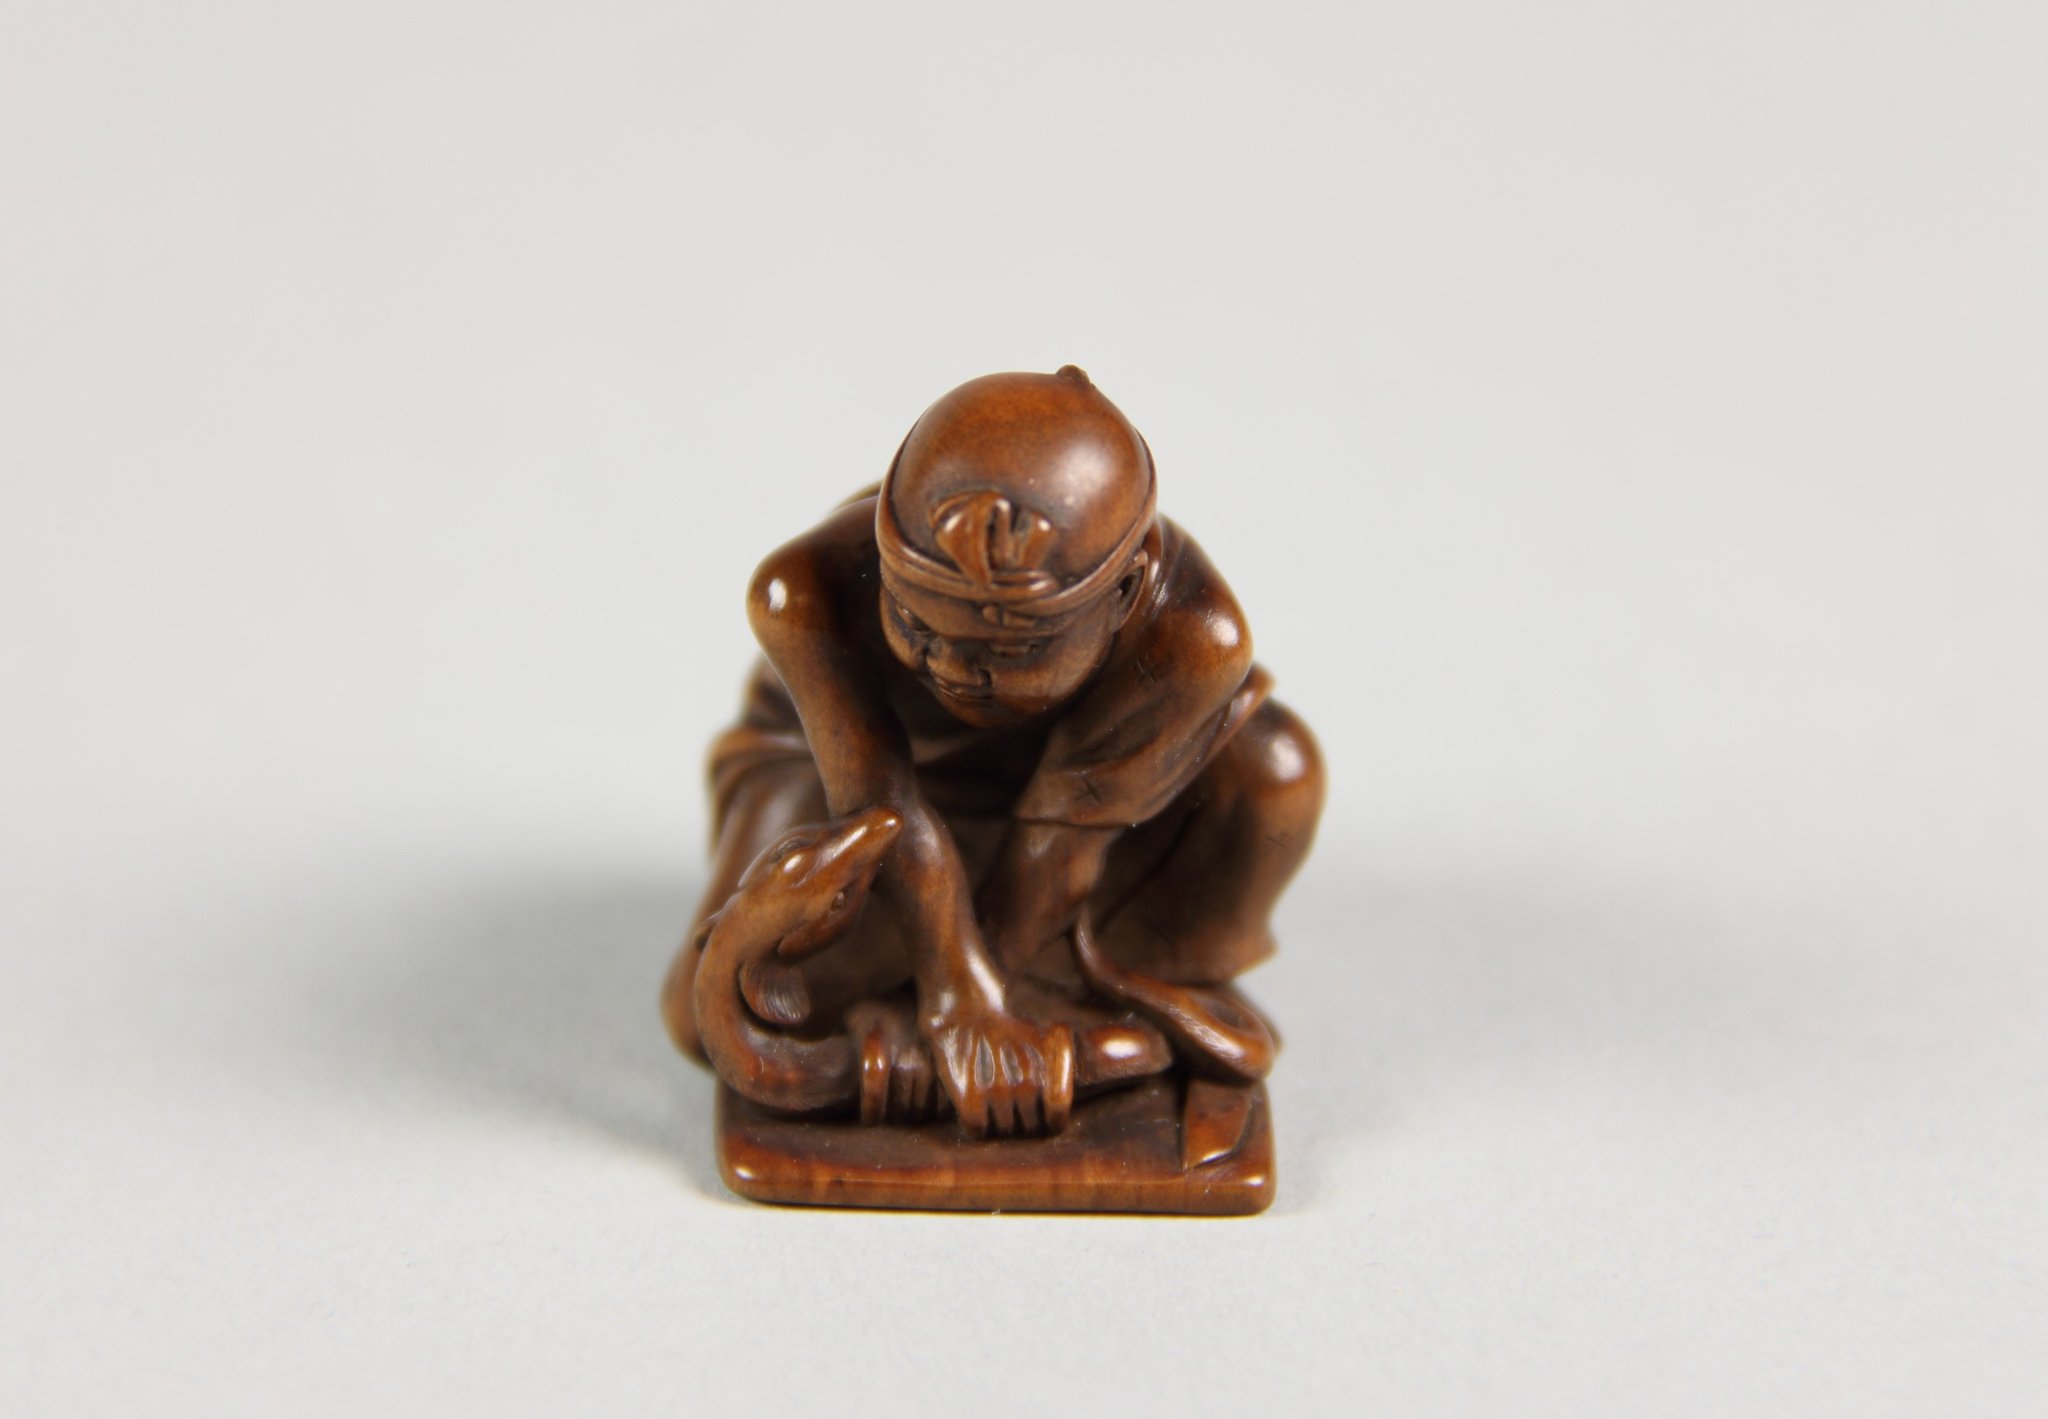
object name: netsuke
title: Netsuke of Boy with a Snake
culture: japanese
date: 1801-1900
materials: wood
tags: boys,snakes